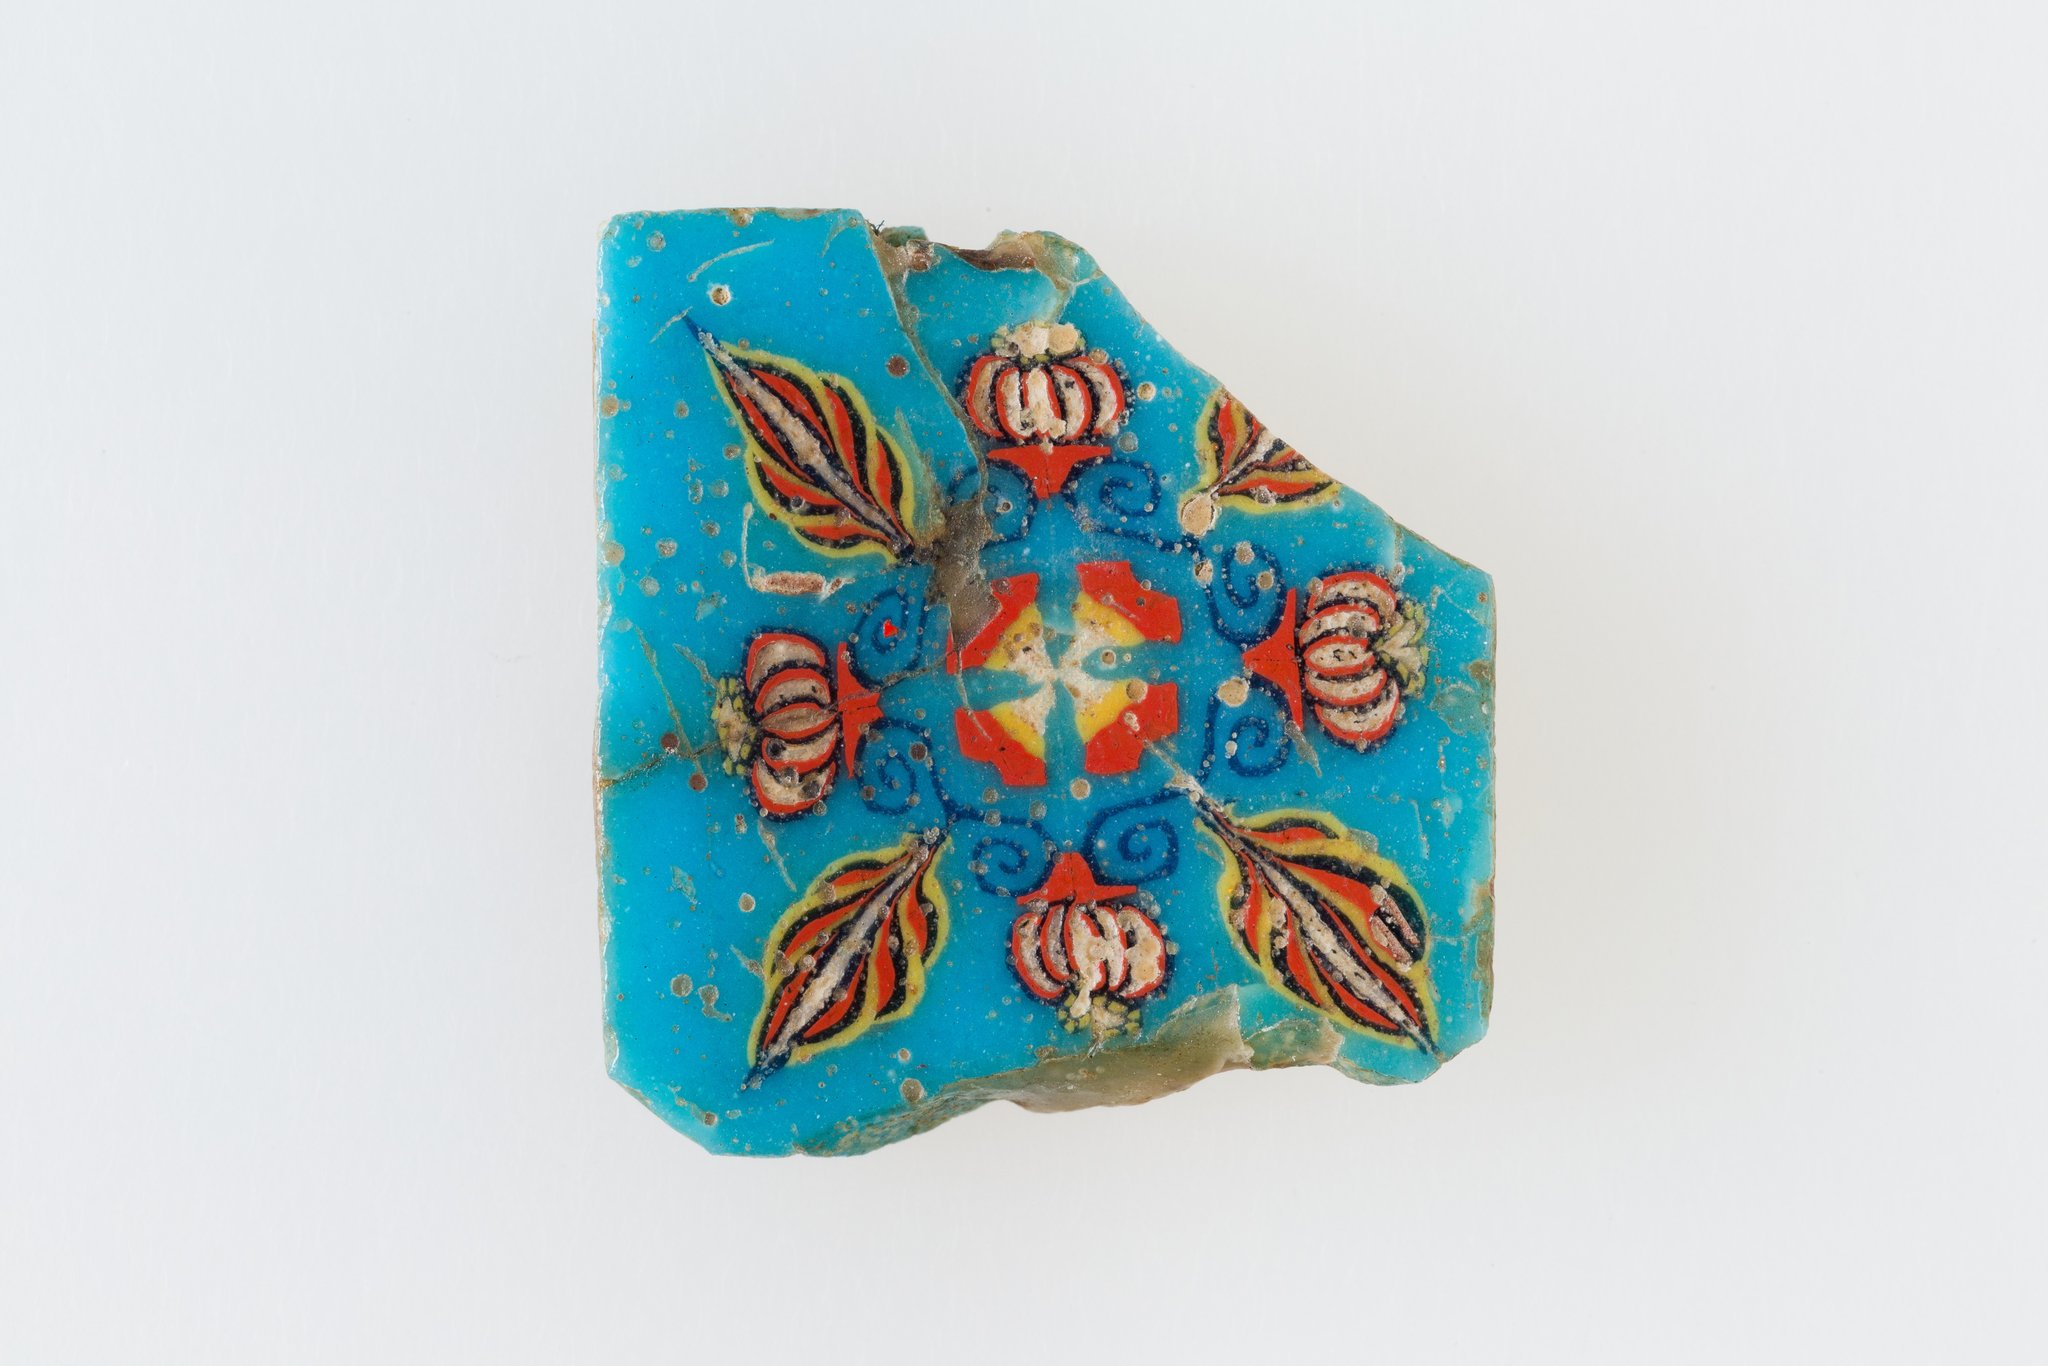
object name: inlay, palmette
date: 100 BCE-100 CE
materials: glass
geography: egypt